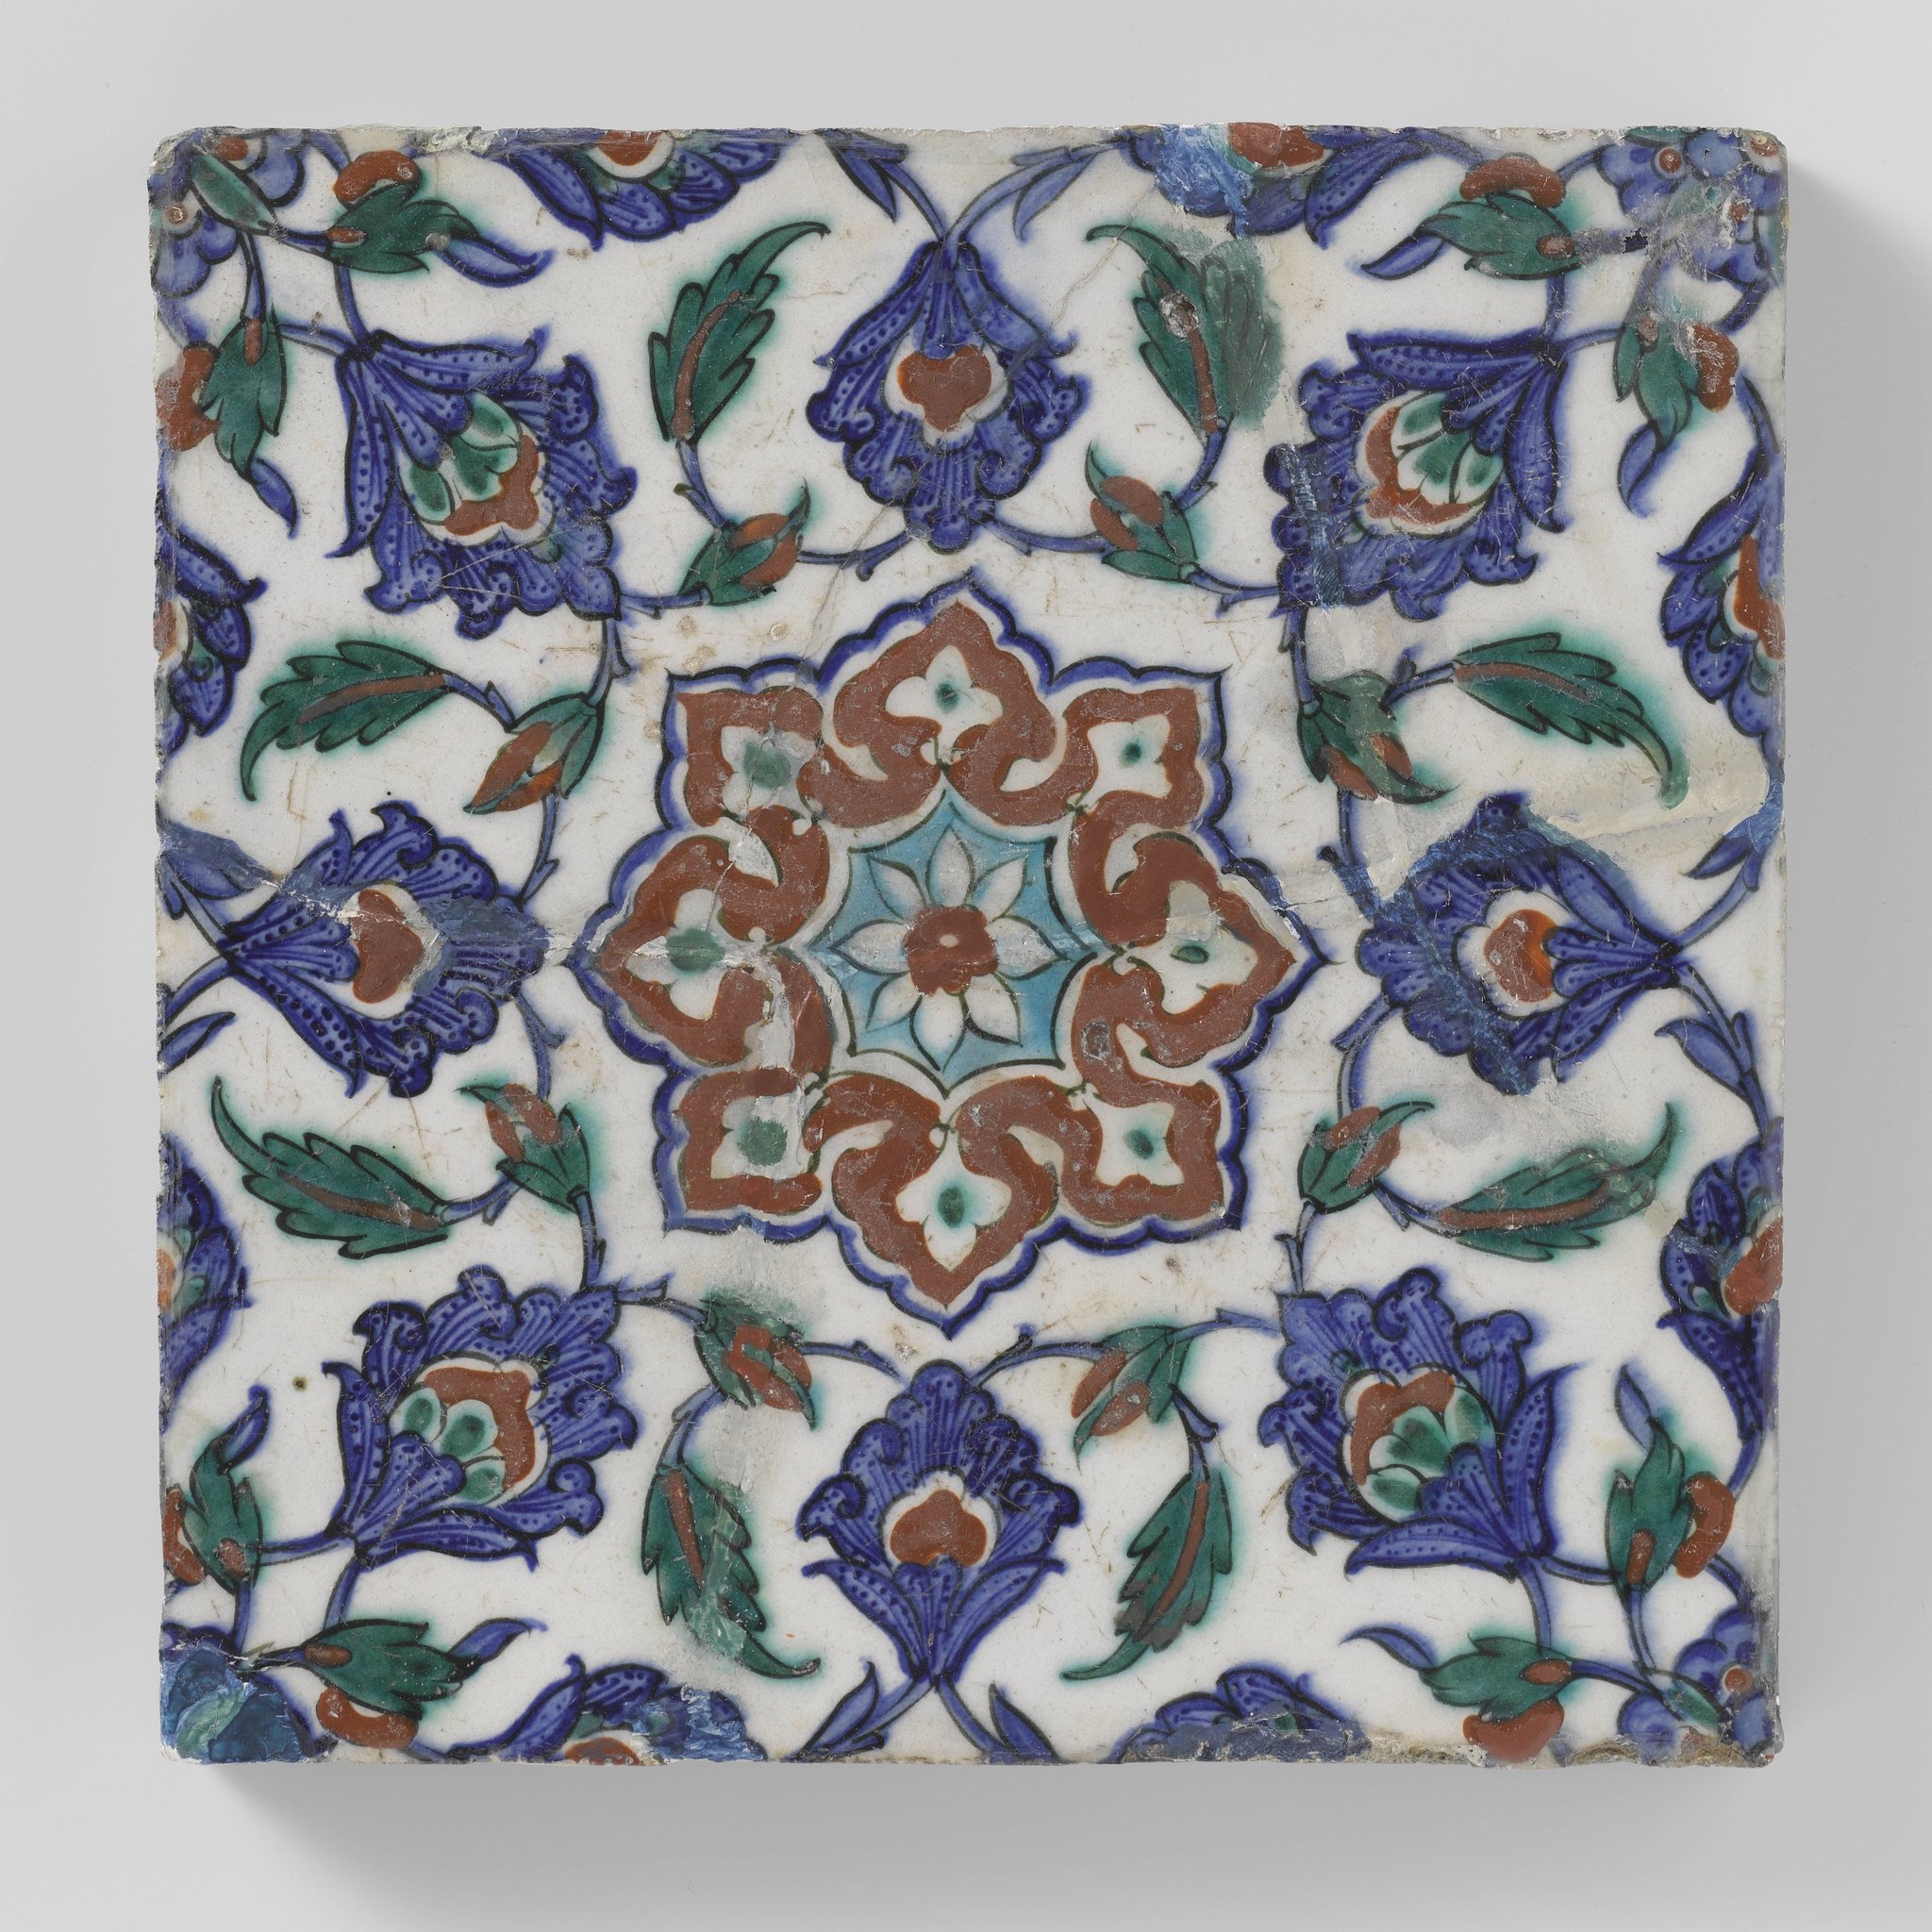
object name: tile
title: Tile with a flower roundel and floral scrolls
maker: Anonymous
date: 1550-1599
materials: earthenware, glaze, paint, quartz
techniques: firing, forming, vitrification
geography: iznik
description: Kwarts-fritgoed met lood tegel gedecoreerd met een bloemrozet en bloemranken in blauw, groen, turquoise en rood onder transparant lood-alkali-tinglazuur. Iznik.